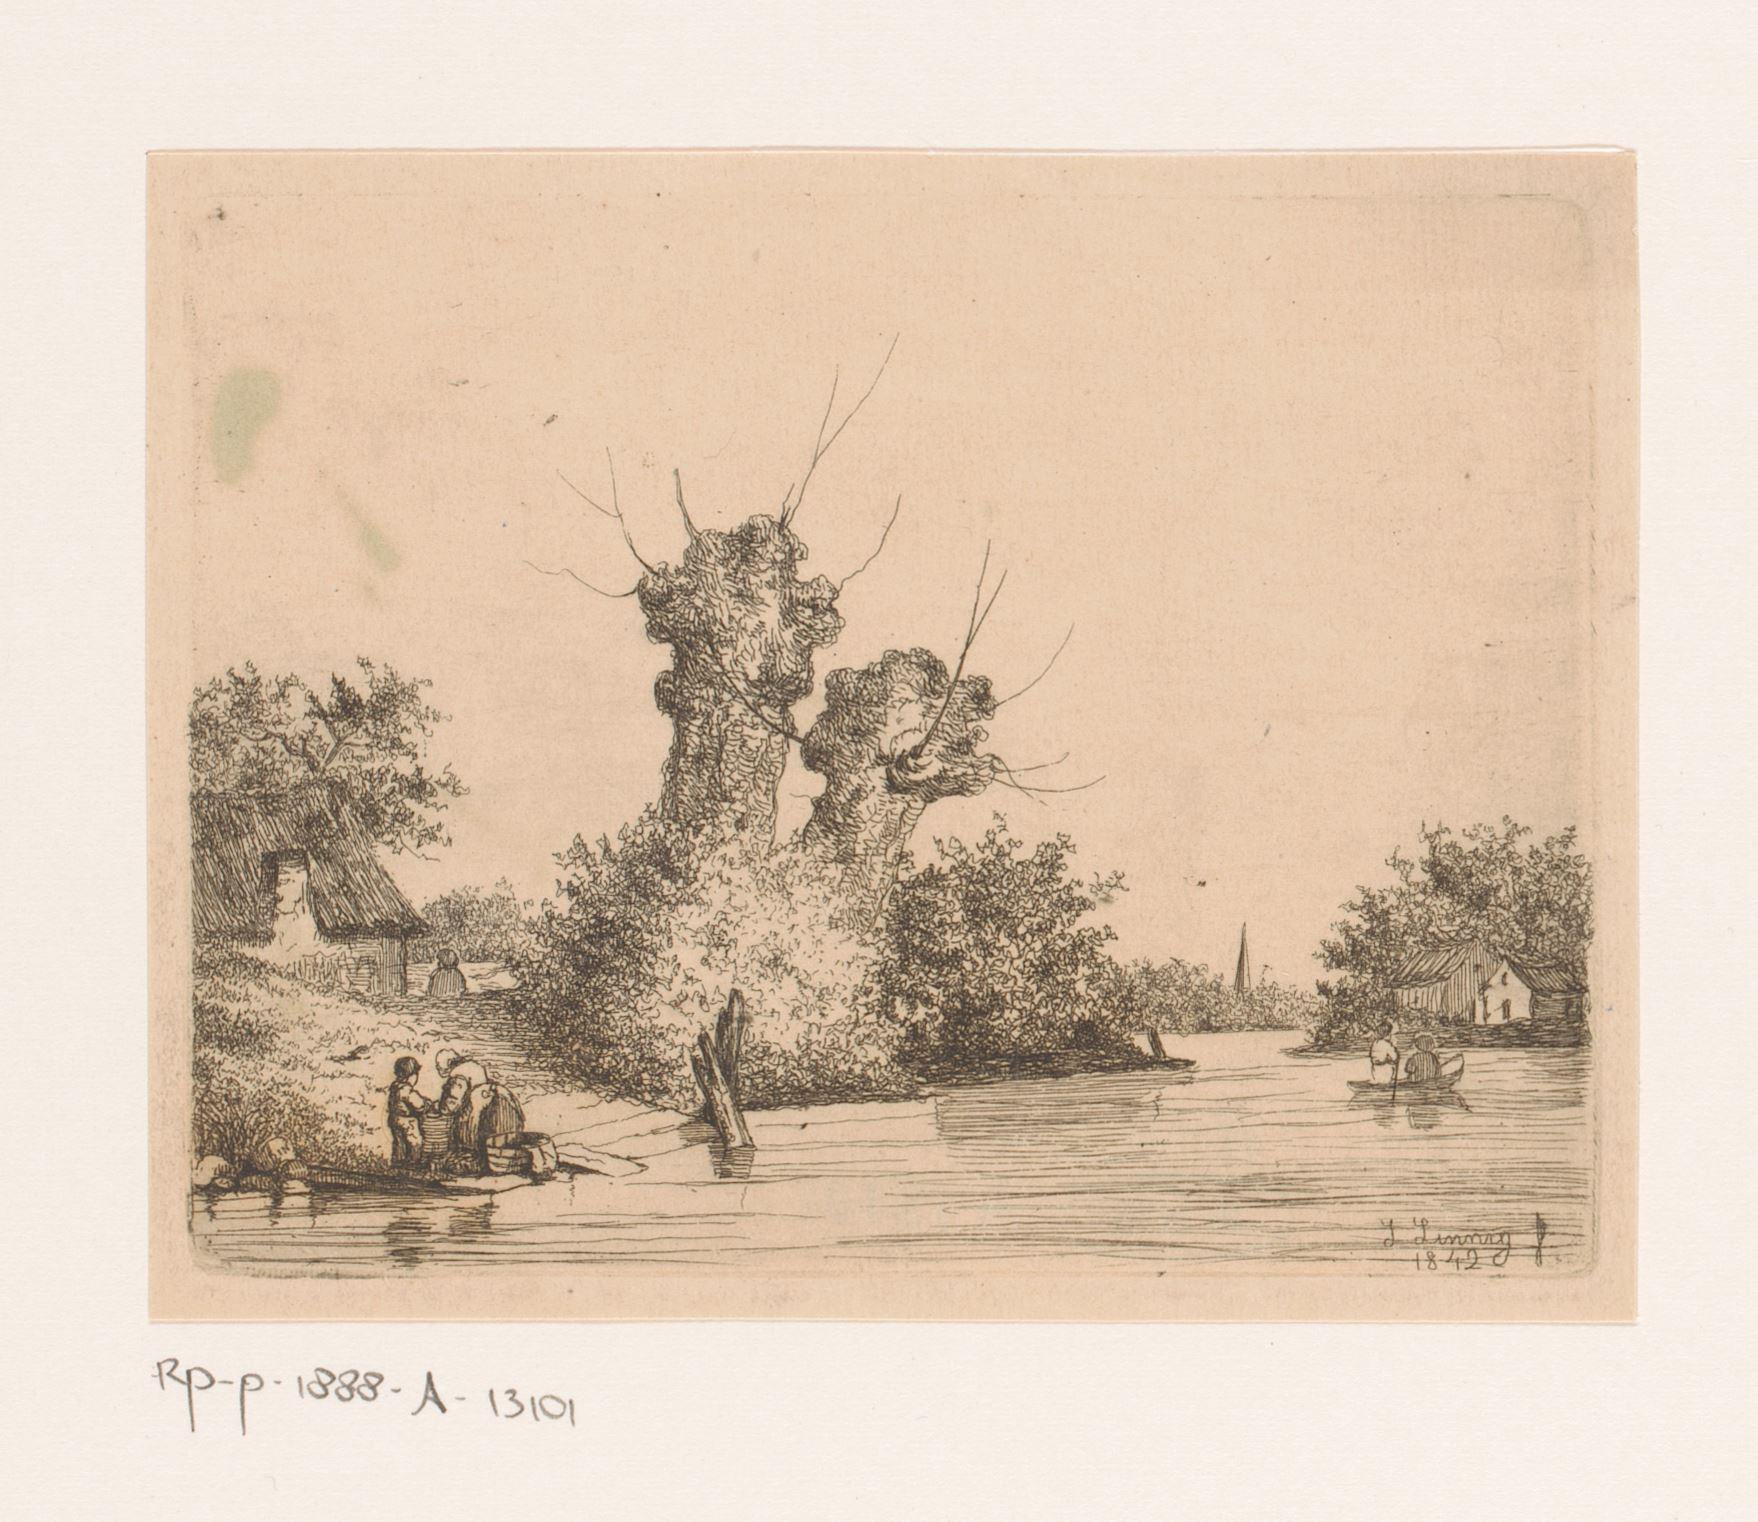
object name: print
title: Rivierlandschap met wilgen bij Deurne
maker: jean théodore joseph linnig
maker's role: draughtsman, print maker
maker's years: 1815-1891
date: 1842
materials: paper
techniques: etching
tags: river, trees: willow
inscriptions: collector's mark: Lugt 2228